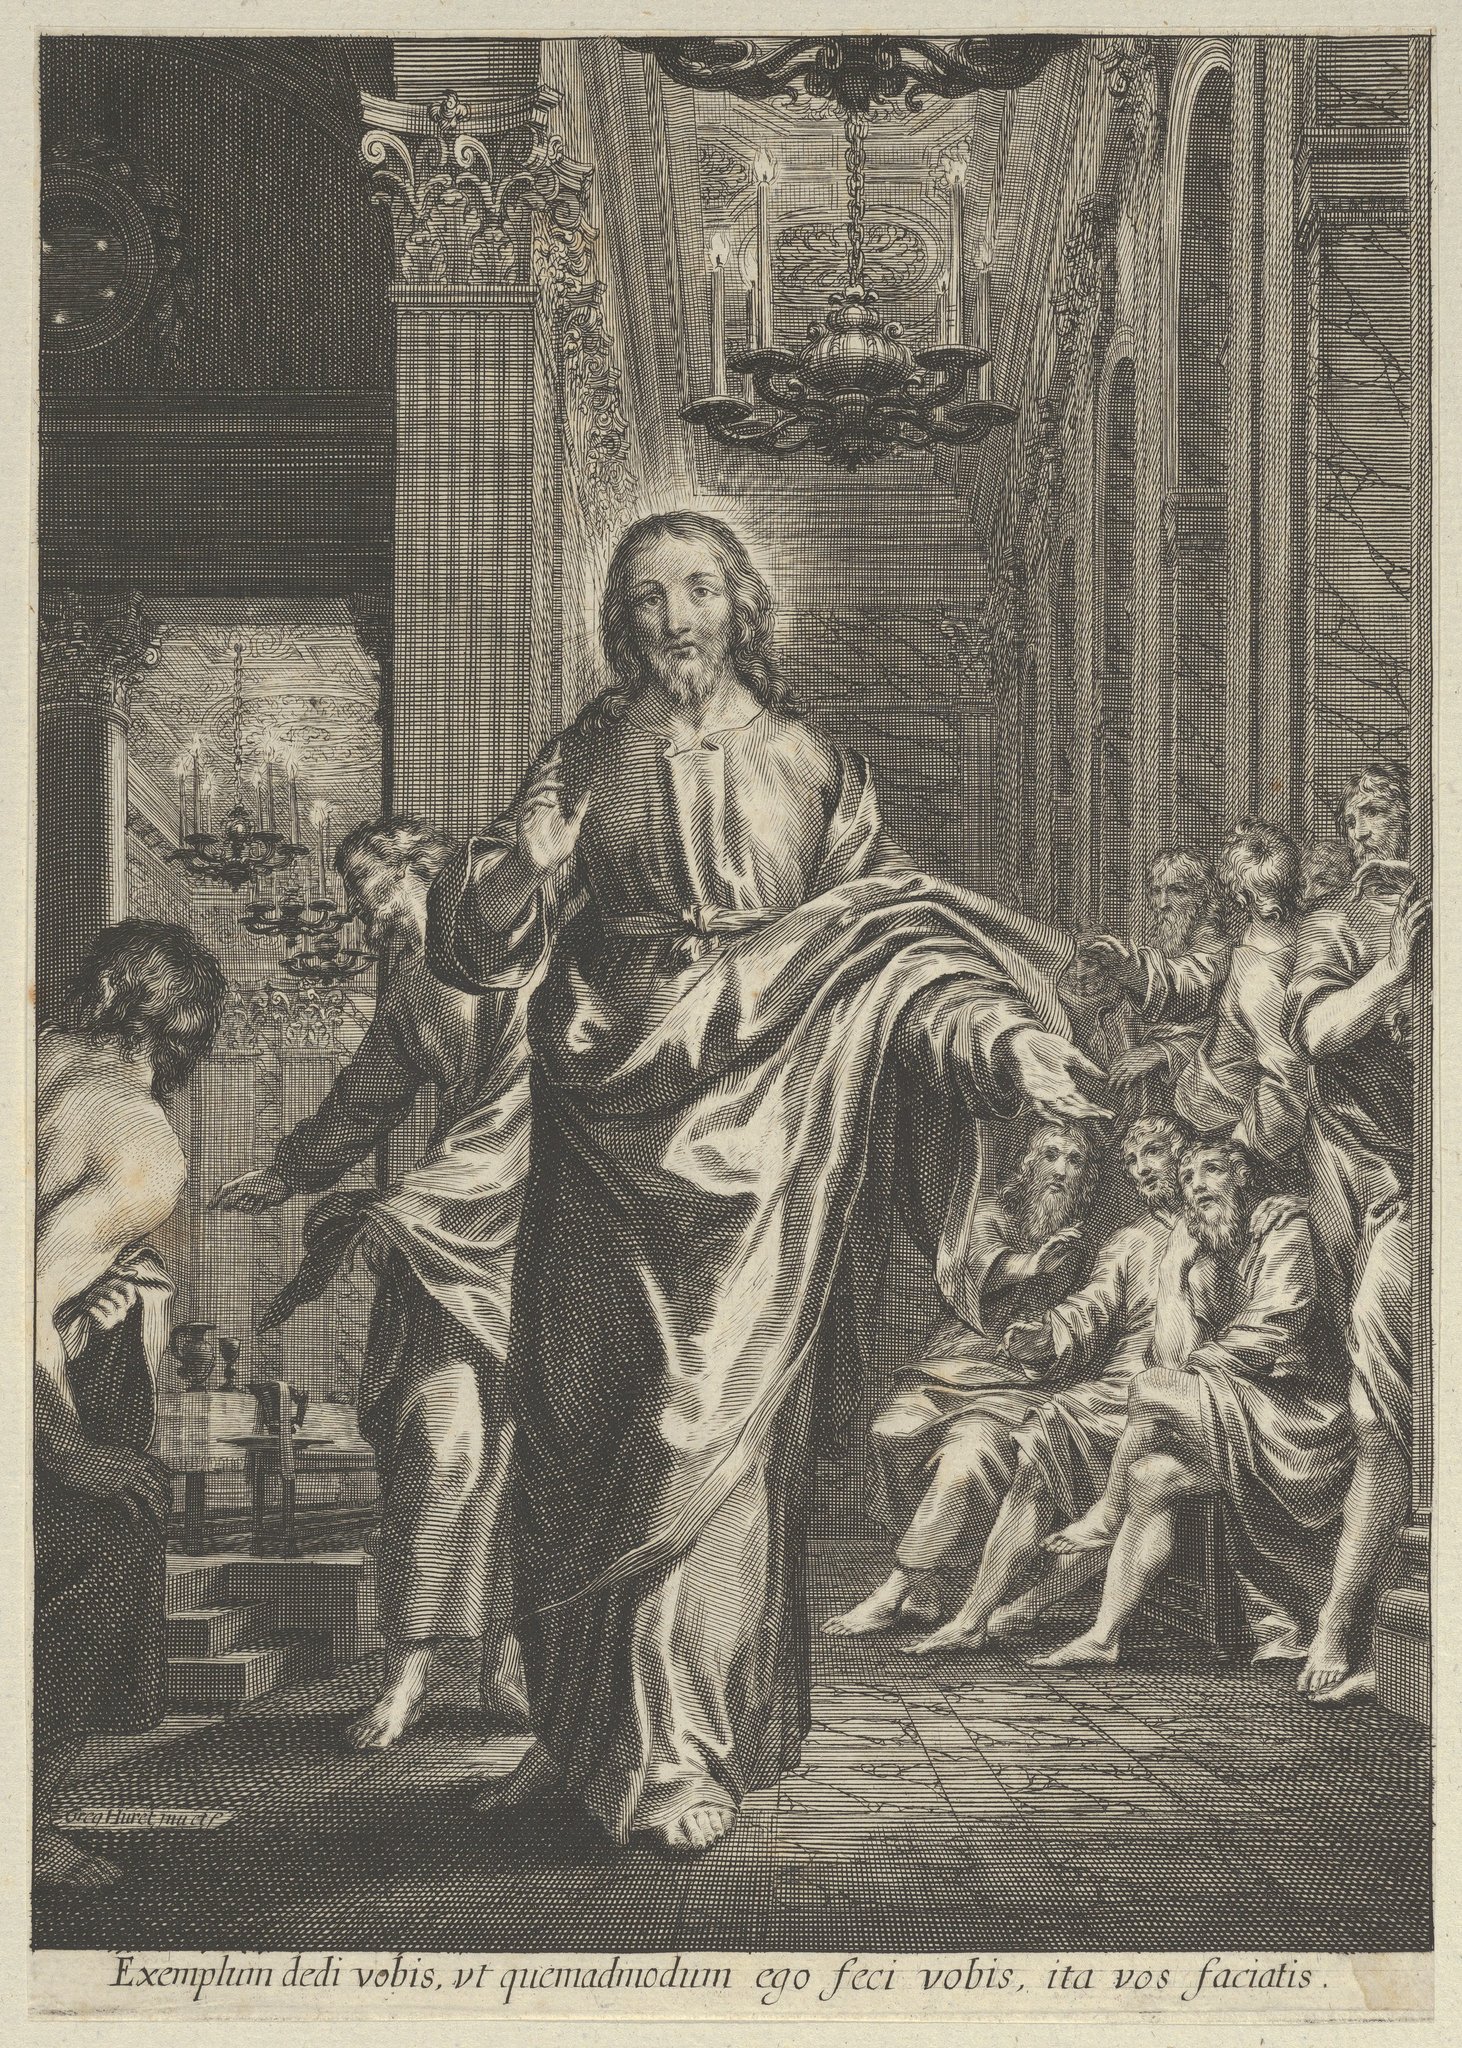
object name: print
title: Christ and his Disciples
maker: grégoire huret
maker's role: artist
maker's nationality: french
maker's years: 1606-1670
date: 1601-1700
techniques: engraving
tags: jesus